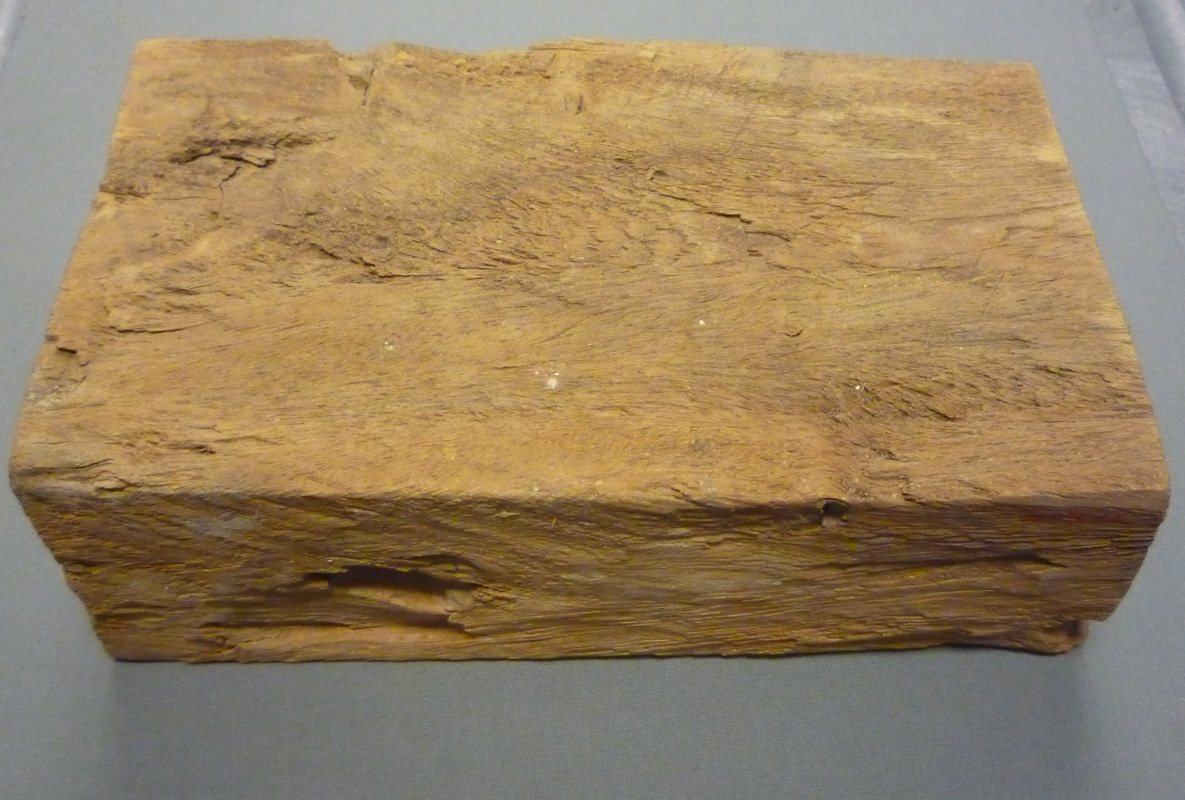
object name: wood block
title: Block of Wood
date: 1479-1458 BCE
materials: wood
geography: egypt